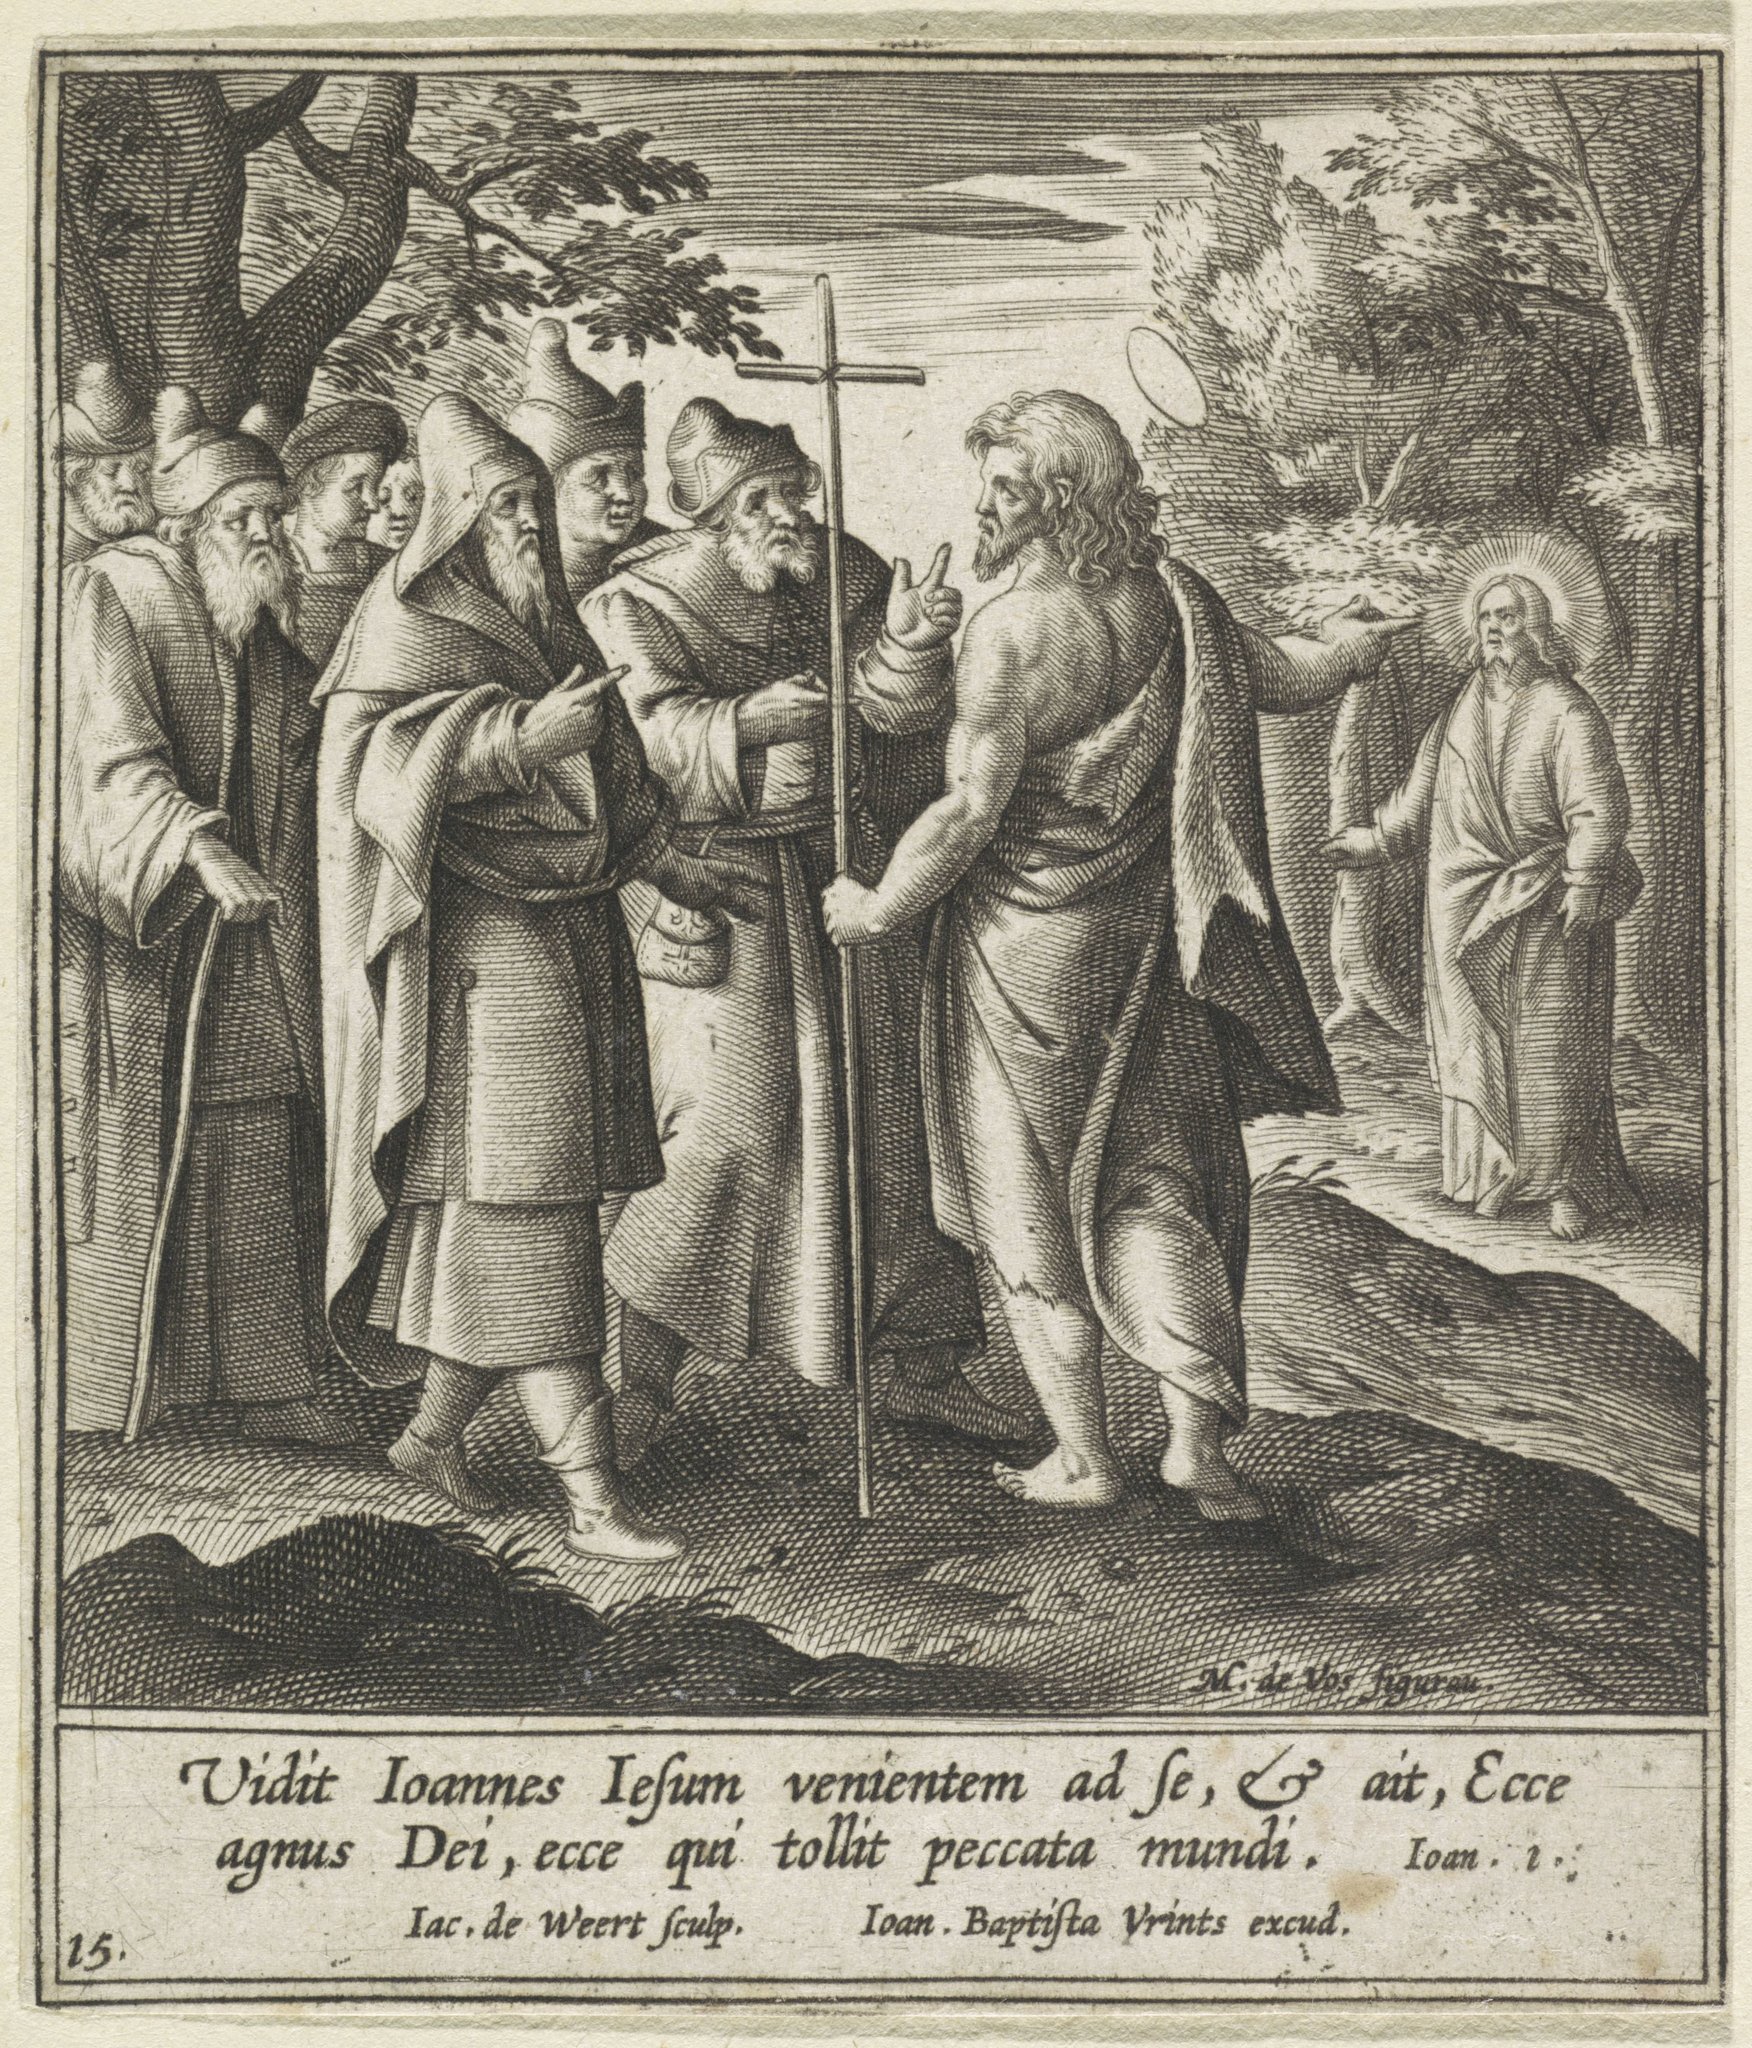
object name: print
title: Johannes de Doper identificeert Christus als het Lam Gods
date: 1580-1600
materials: paper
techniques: engraving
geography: antwerp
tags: john the baptist identifies christ as the lamb of god ('ecce agnus dei') (john 1:29, 1:36)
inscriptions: collector's mark: Lugt 240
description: Johannes de Doper houdt een kruis vast. Hij wijst naar Christus en identificeert hem ten overstaan van de priesters en de Levieten als het Lam Gods dat de zonden van de wereld wegneemt. Onder de voorstelling bevindt zich een tweeregelige, Latijnse tekst met de beschrijving van de scène uit Joh. 1.